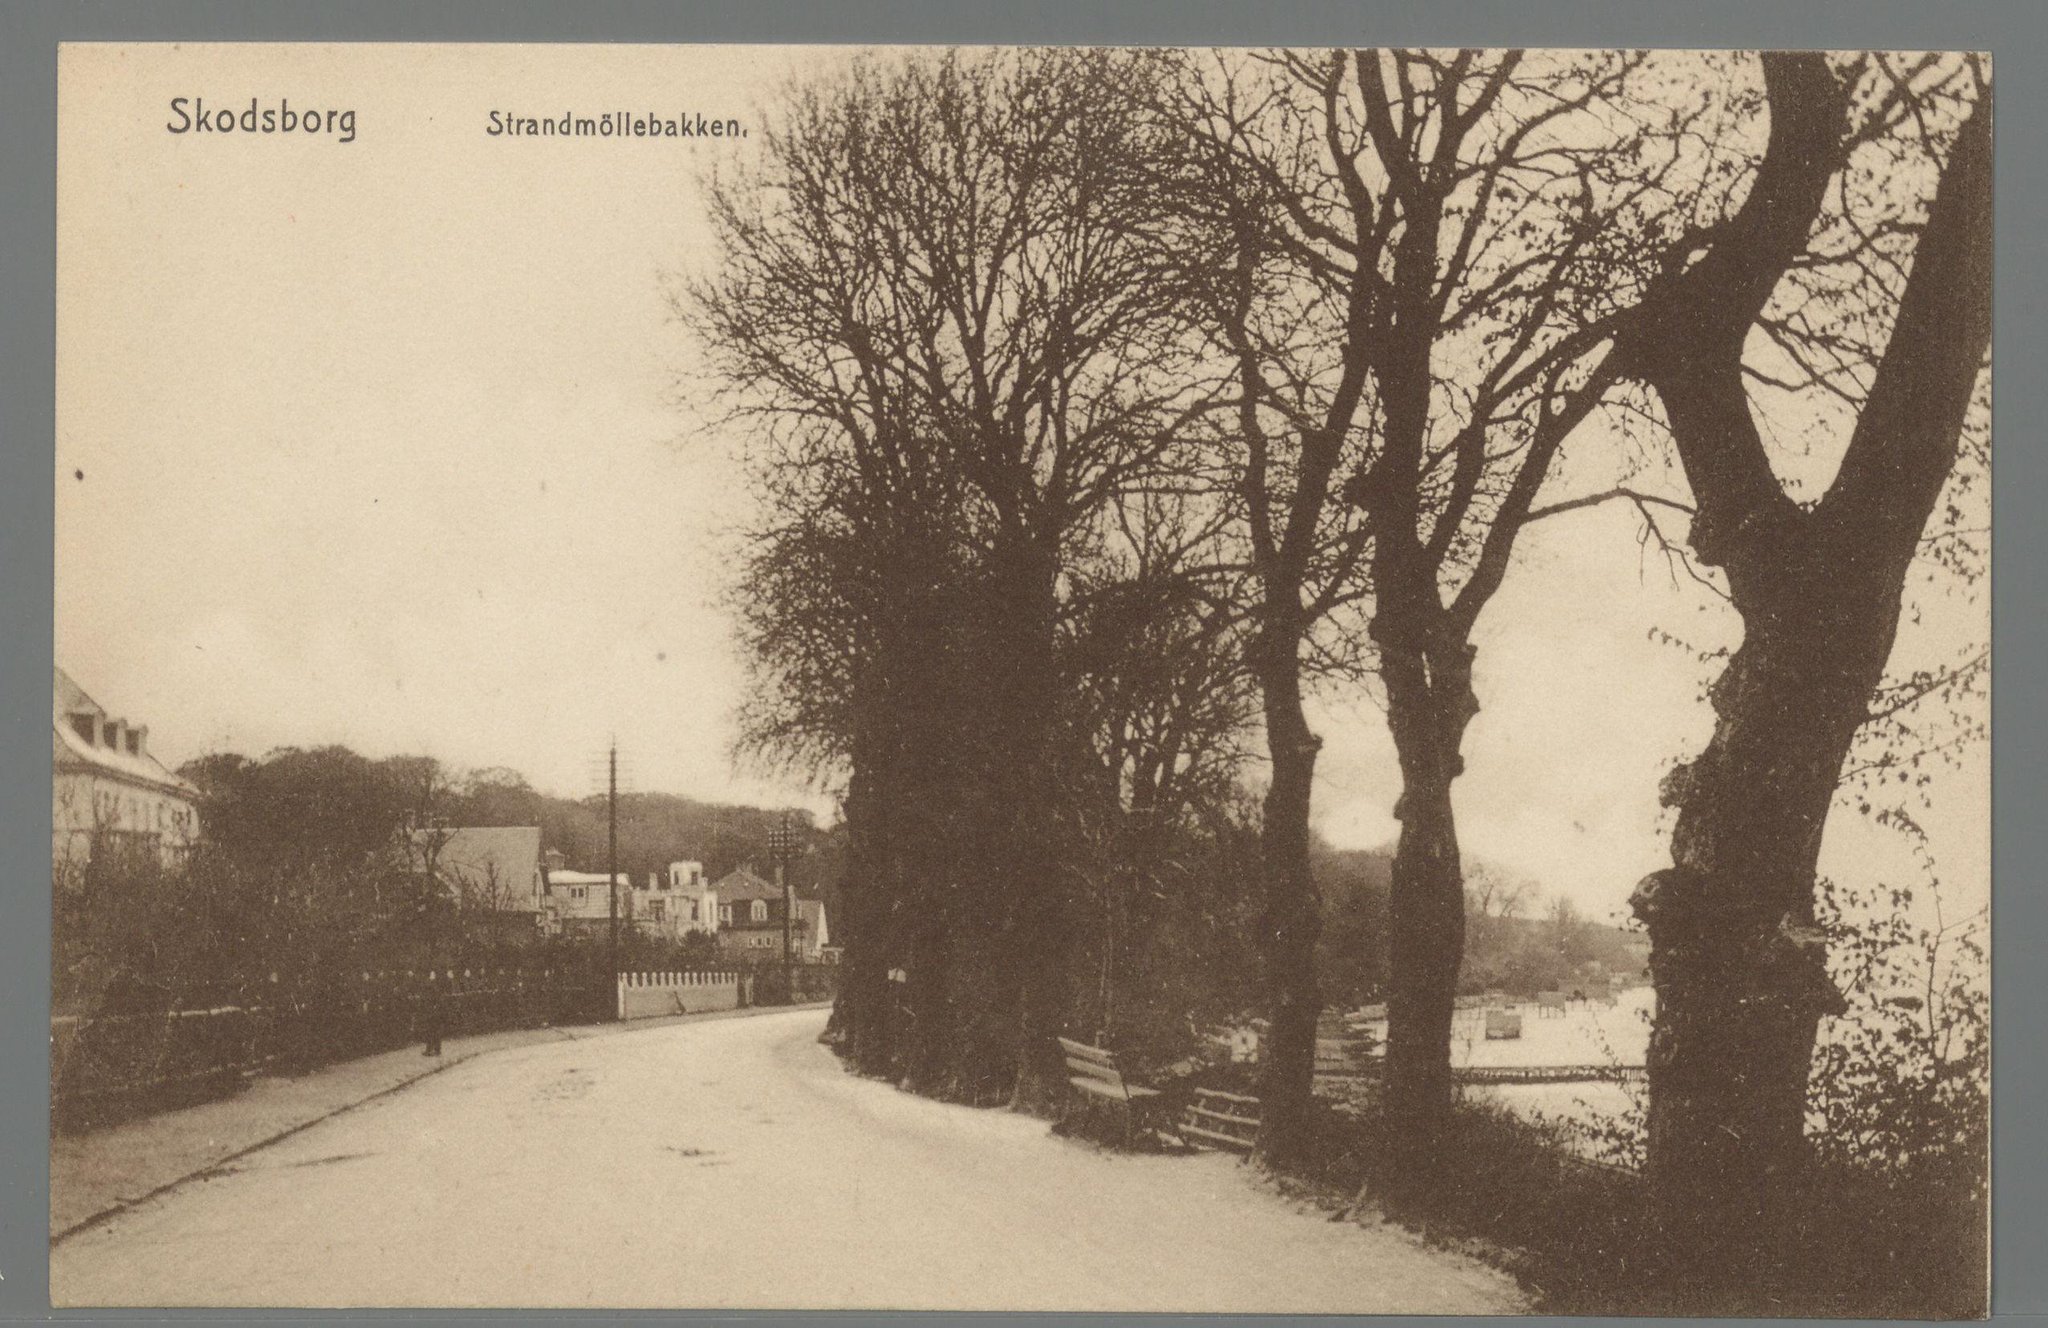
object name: photomechanical print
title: Skodsborg. Strandmöllebakken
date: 1906-1920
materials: cardboard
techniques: photograph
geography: denmark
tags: village street, coast